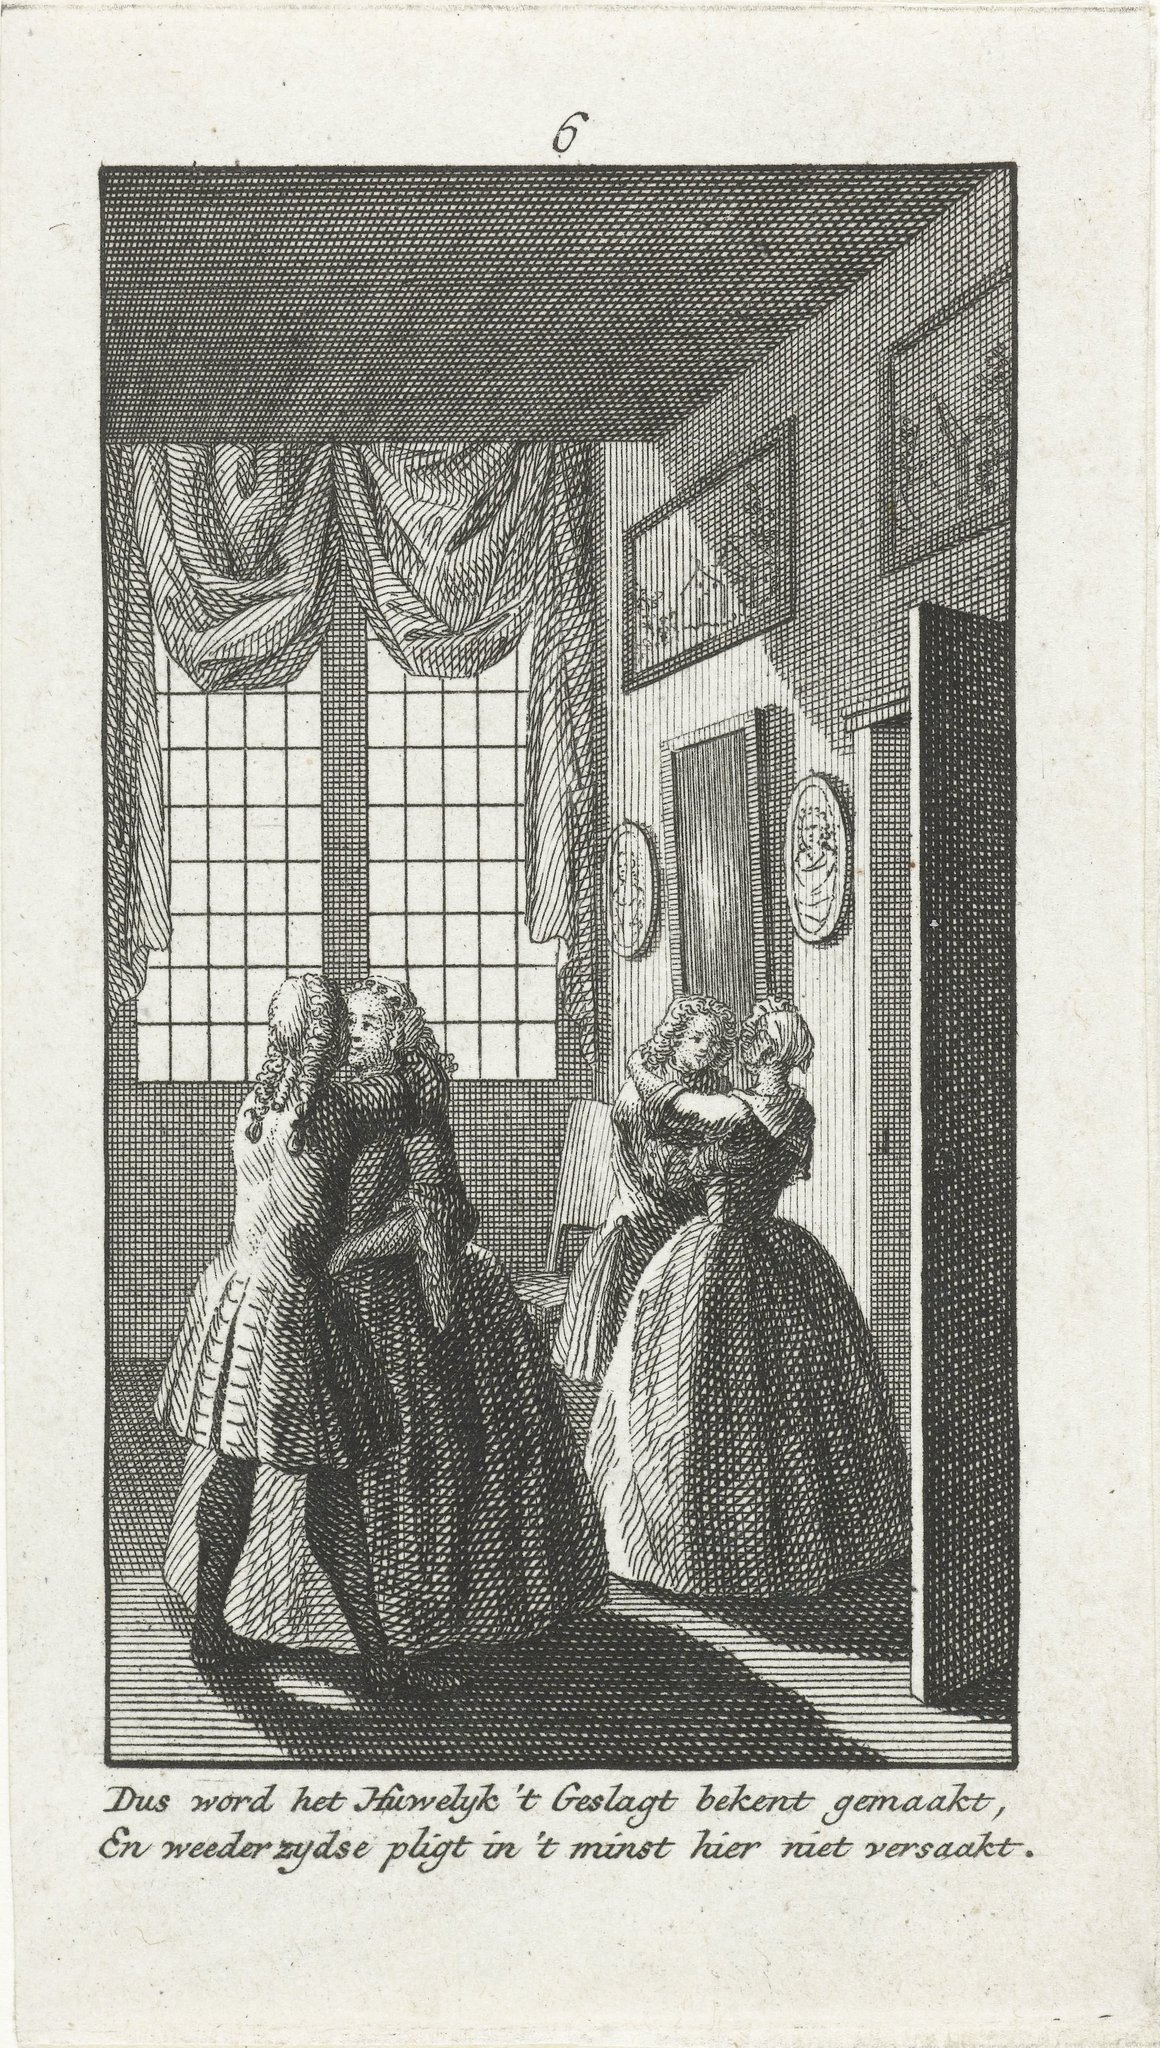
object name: print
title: Bekendmaking van het huwelijk aan familie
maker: jan caspar philips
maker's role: draughtsman, print maker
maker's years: 1700-1775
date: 1740-1760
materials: paper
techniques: engraving, etching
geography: northern netherlands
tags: betrothal and marriage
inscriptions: caption: ‘Dus wordt het Huwelijk ... hier niet versaakt.’, collector's mark: Lugt 2228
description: De bekendmaking van het aanstaande huwelijk aan leden van de familie. Interieur met man die jonge vrouw en vrouw die jongeman omhelst. Prent nr. 6 in een serie van twaalf prentjes met tweeregelige versjes over de Hollandse gewoontes bij het huwelijk ca. 1750.